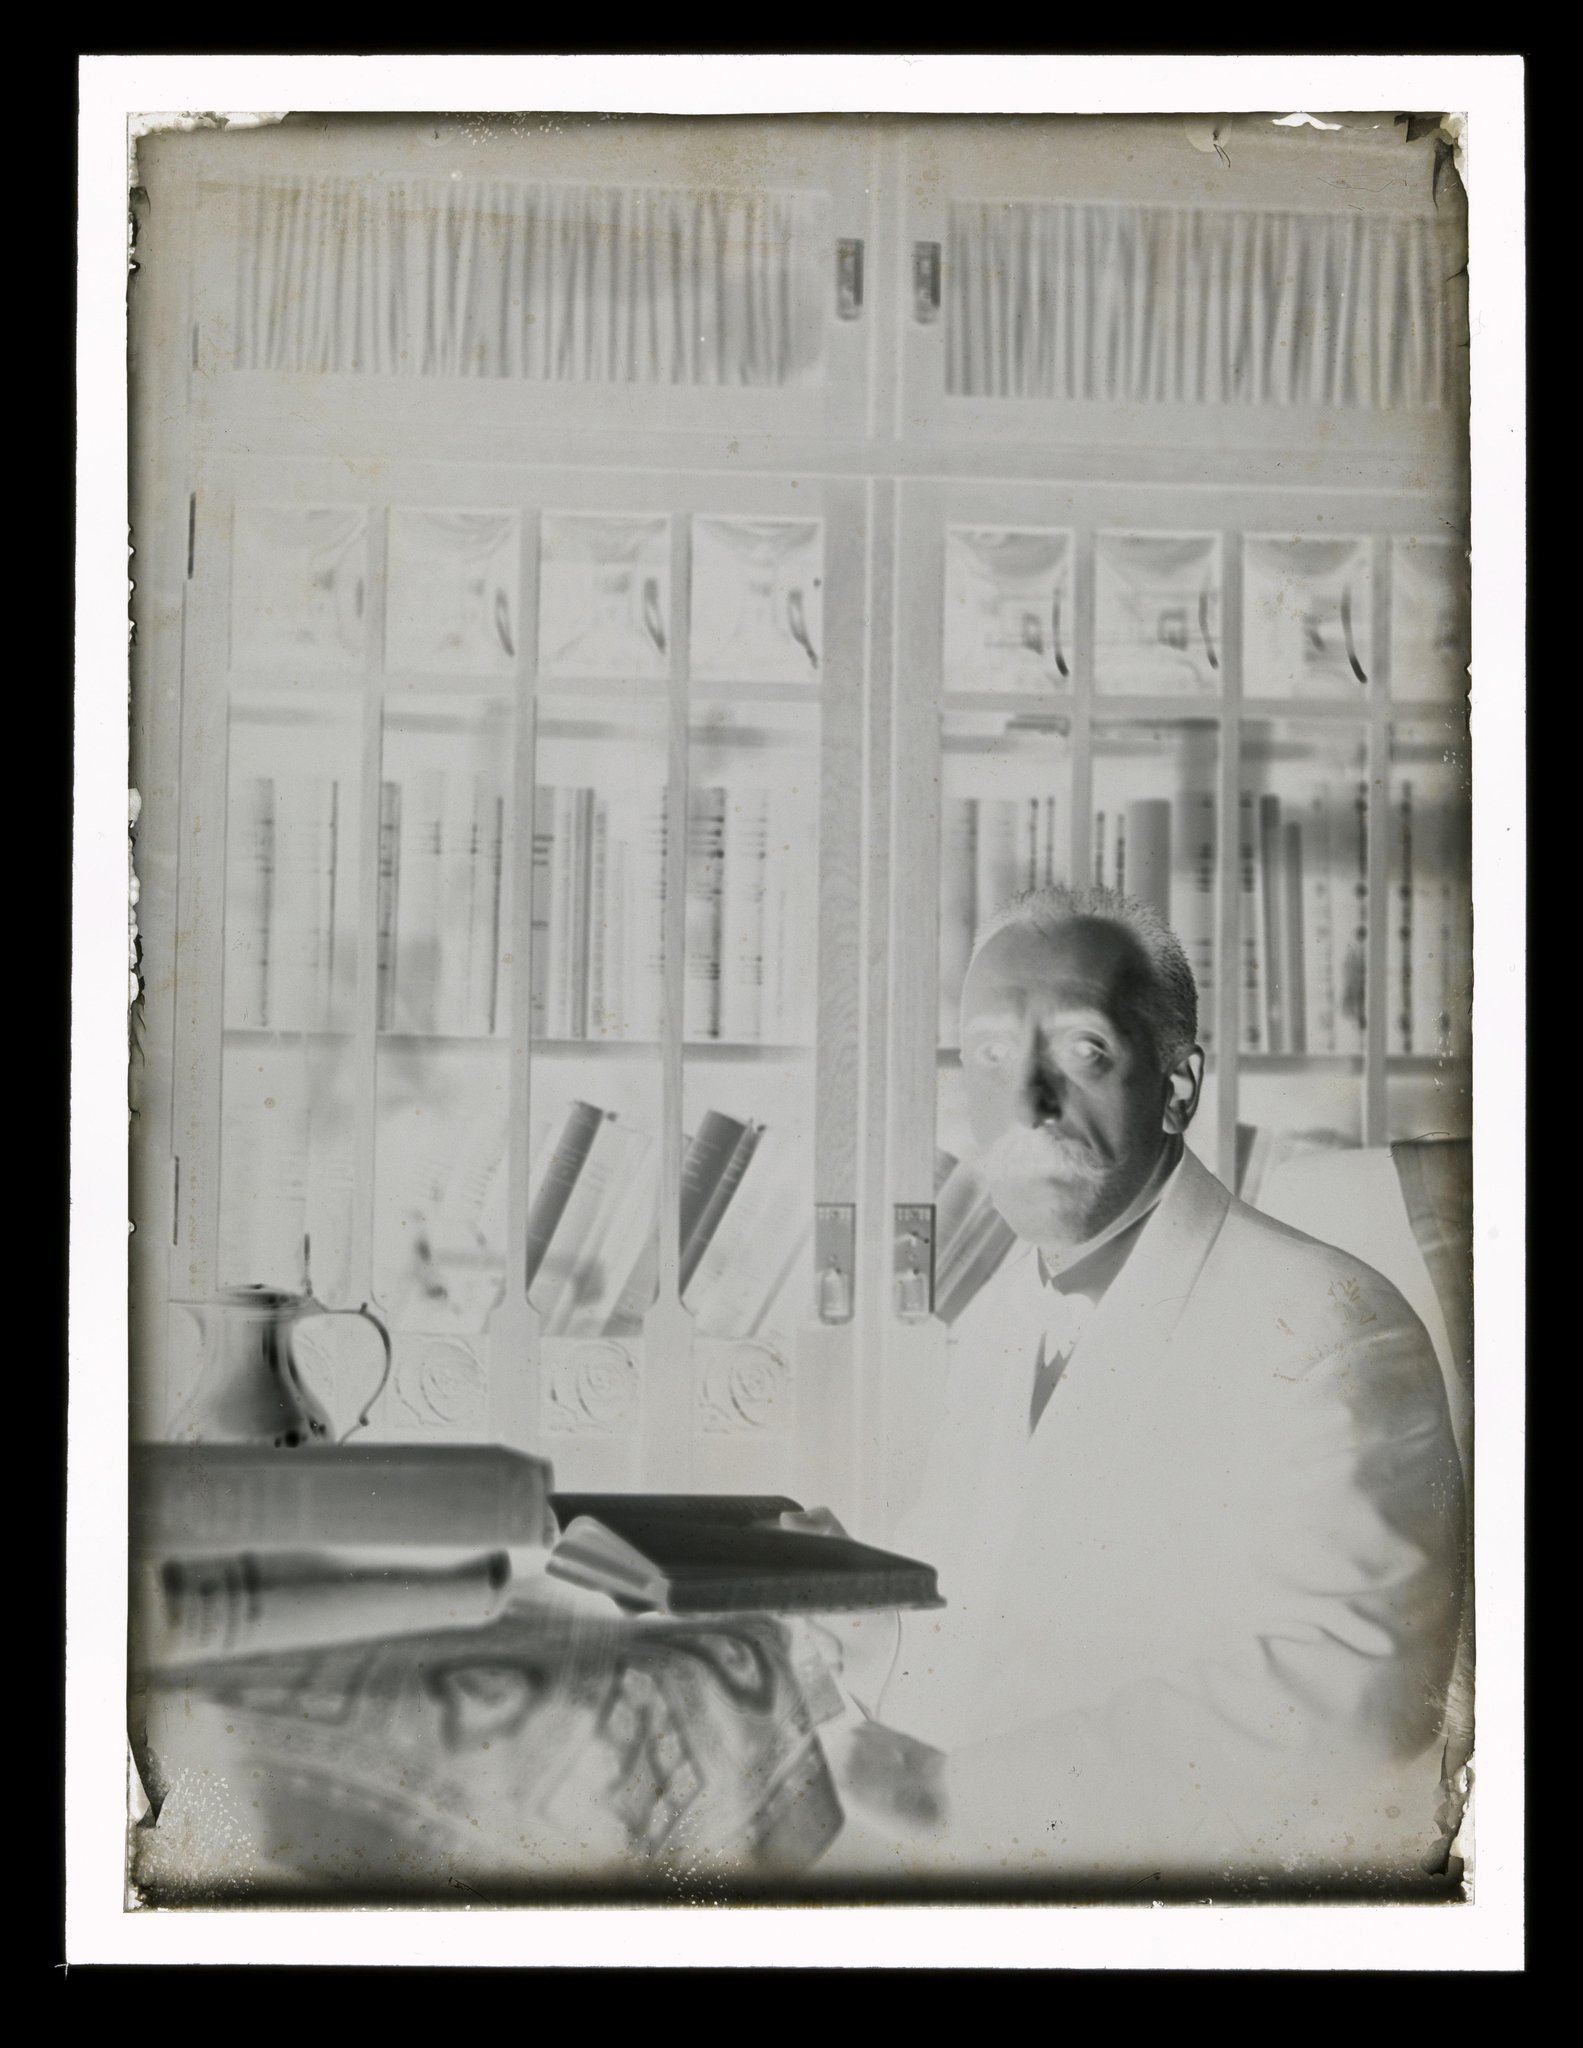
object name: glasnegatief, glasplaatnegatief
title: Portret van een onbekende man aan een bureau voor een boekenkast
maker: Anonymous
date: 1907-1935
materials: glass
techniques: gelatin glass negative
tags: bookcase, with doors, study; 'studiolo'; library, historical persons not known by name